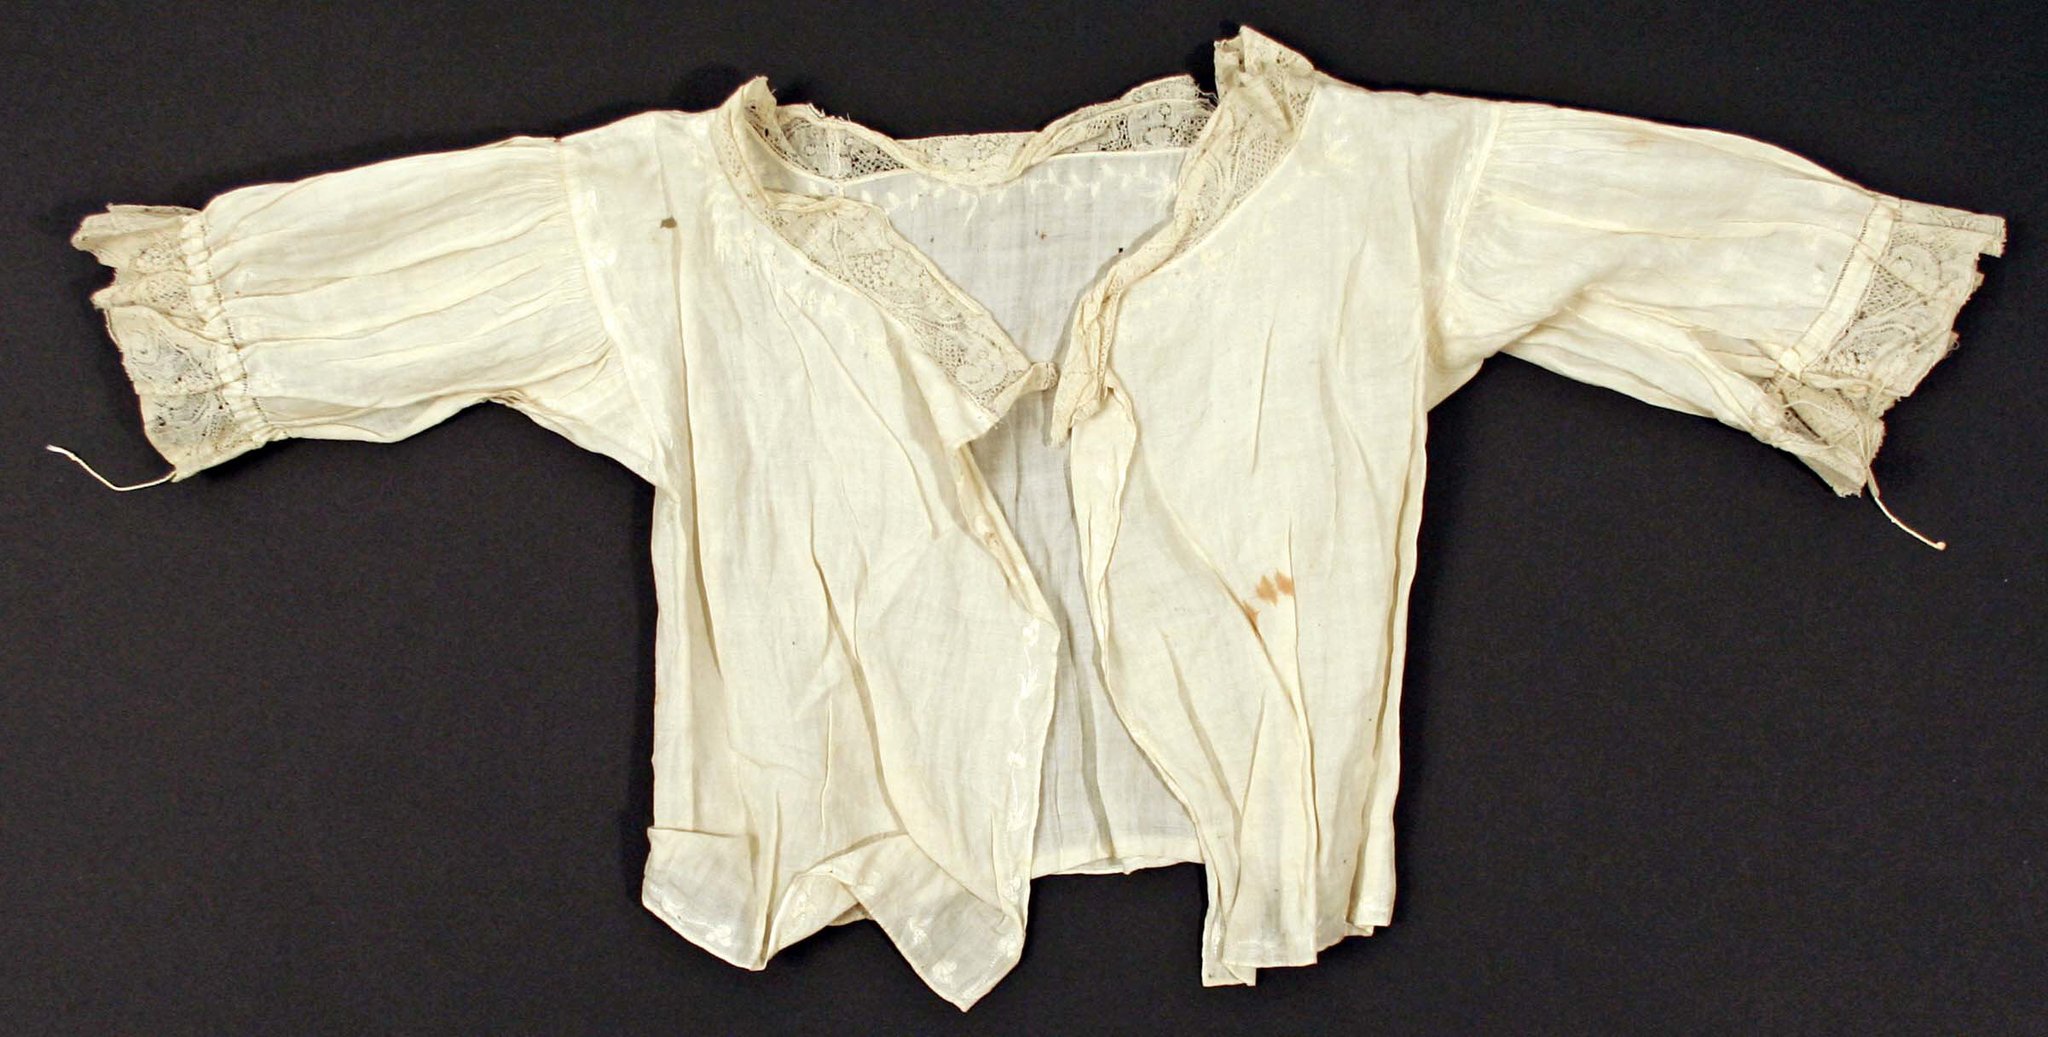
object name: shirt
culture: french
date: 1800-1825